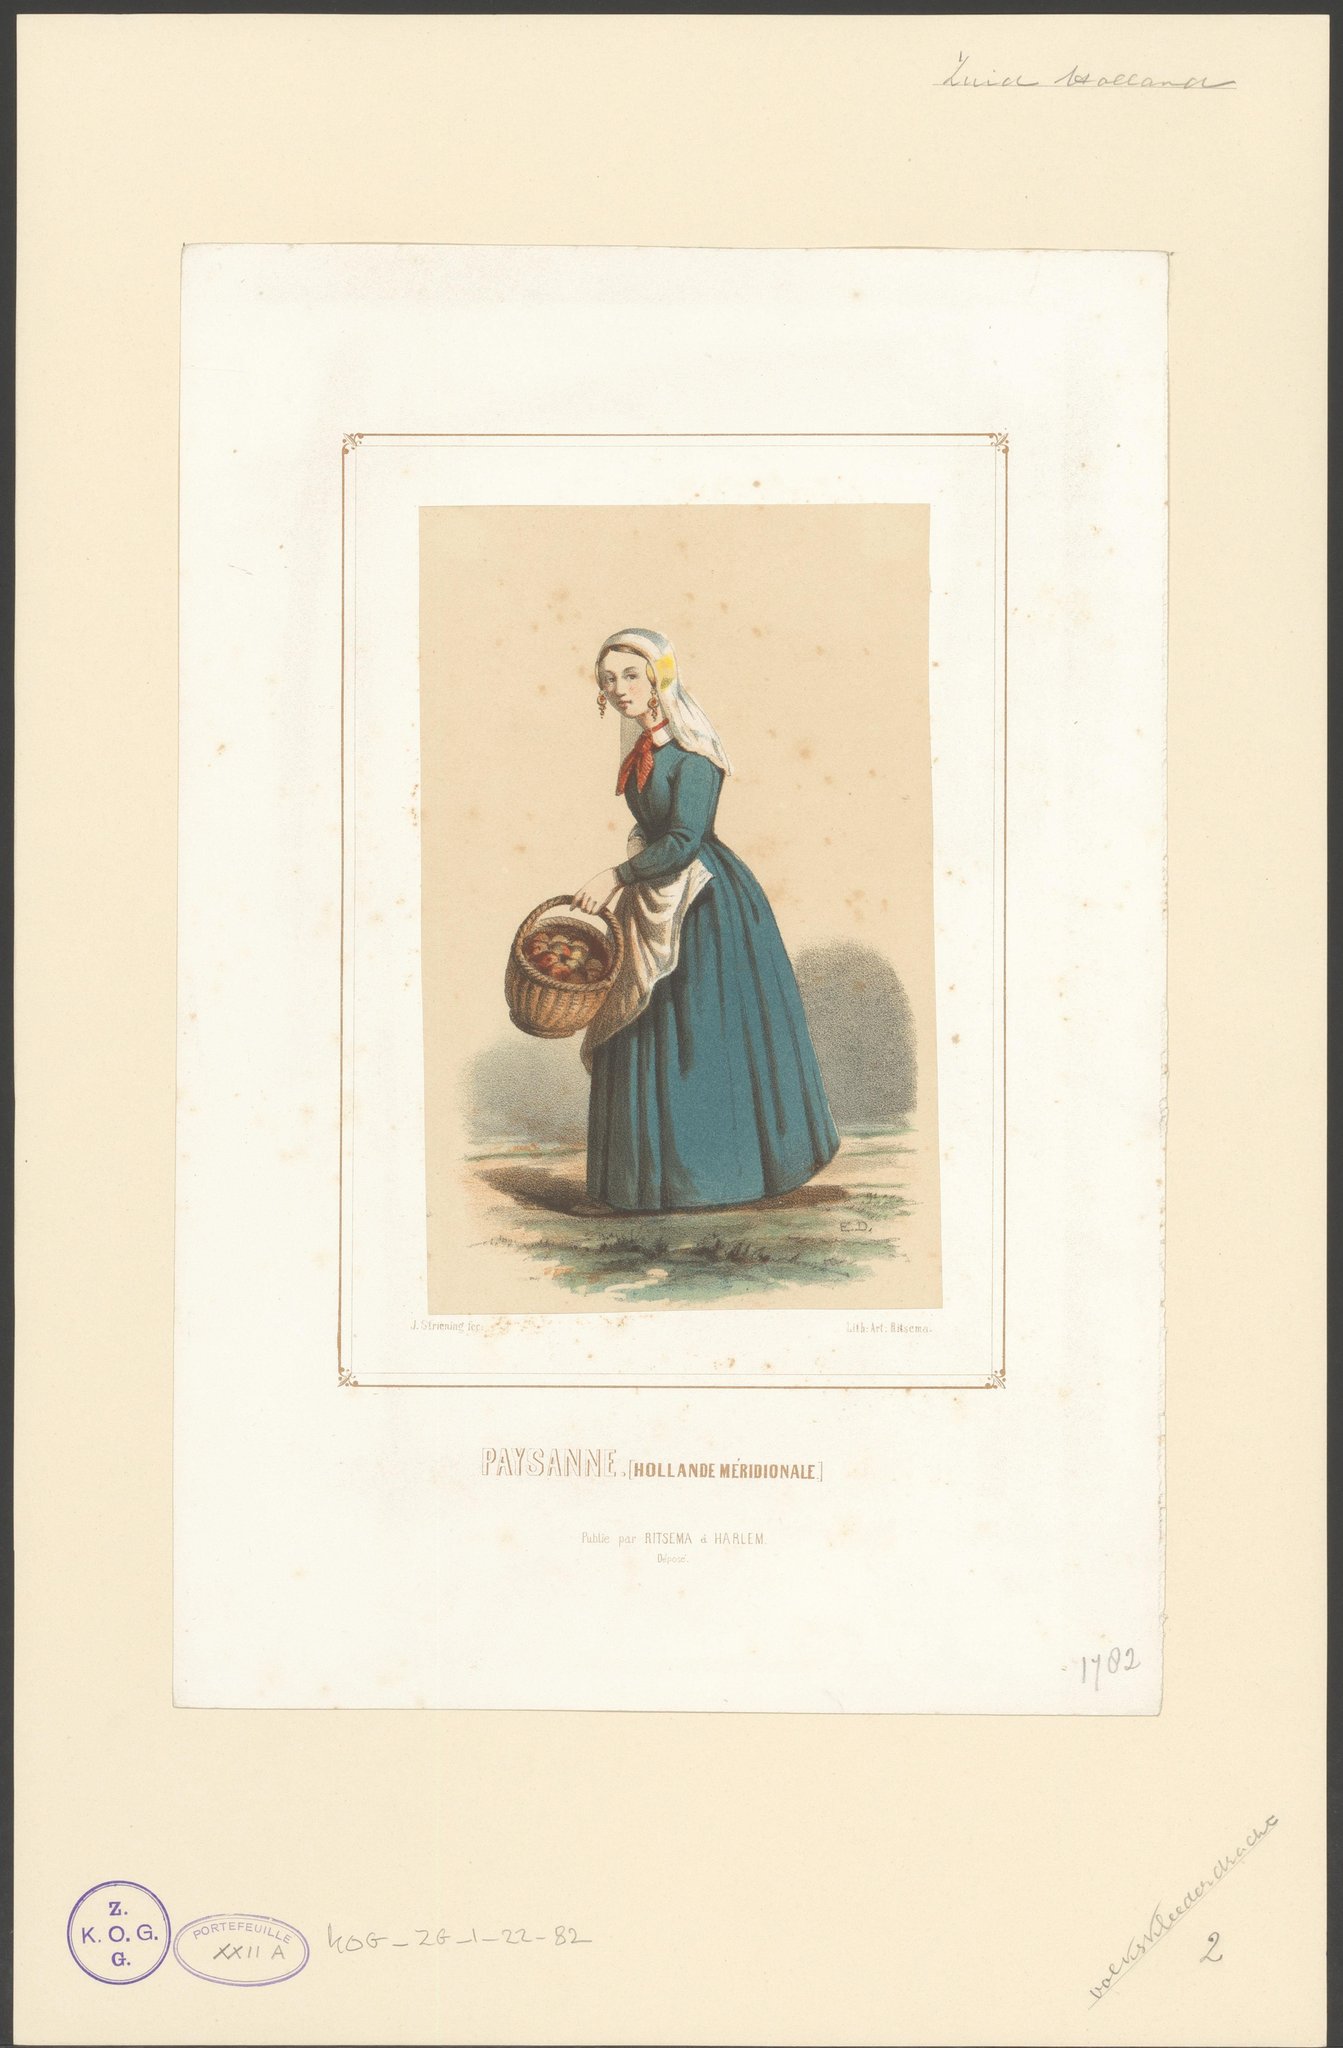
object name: print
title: Paysanne. [Hollande Mériondionale.]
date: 1858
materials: paper, watercolor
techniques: hand coloring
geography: haarlem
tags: farmers - aa - female farmer, farmer's wife, clothes, costume (+ women's clothes), folk costume, regional costume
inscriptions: collector's mark, collector's mark: Lugt 1641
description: Jonge boerin uit Zuid-Holland, met mand met fruit. Onderwerpsrubrieken binnen de Atlas Zeden en Gewoonten: De Kleeding, Volkskleederdracht, Zuid-Holland.